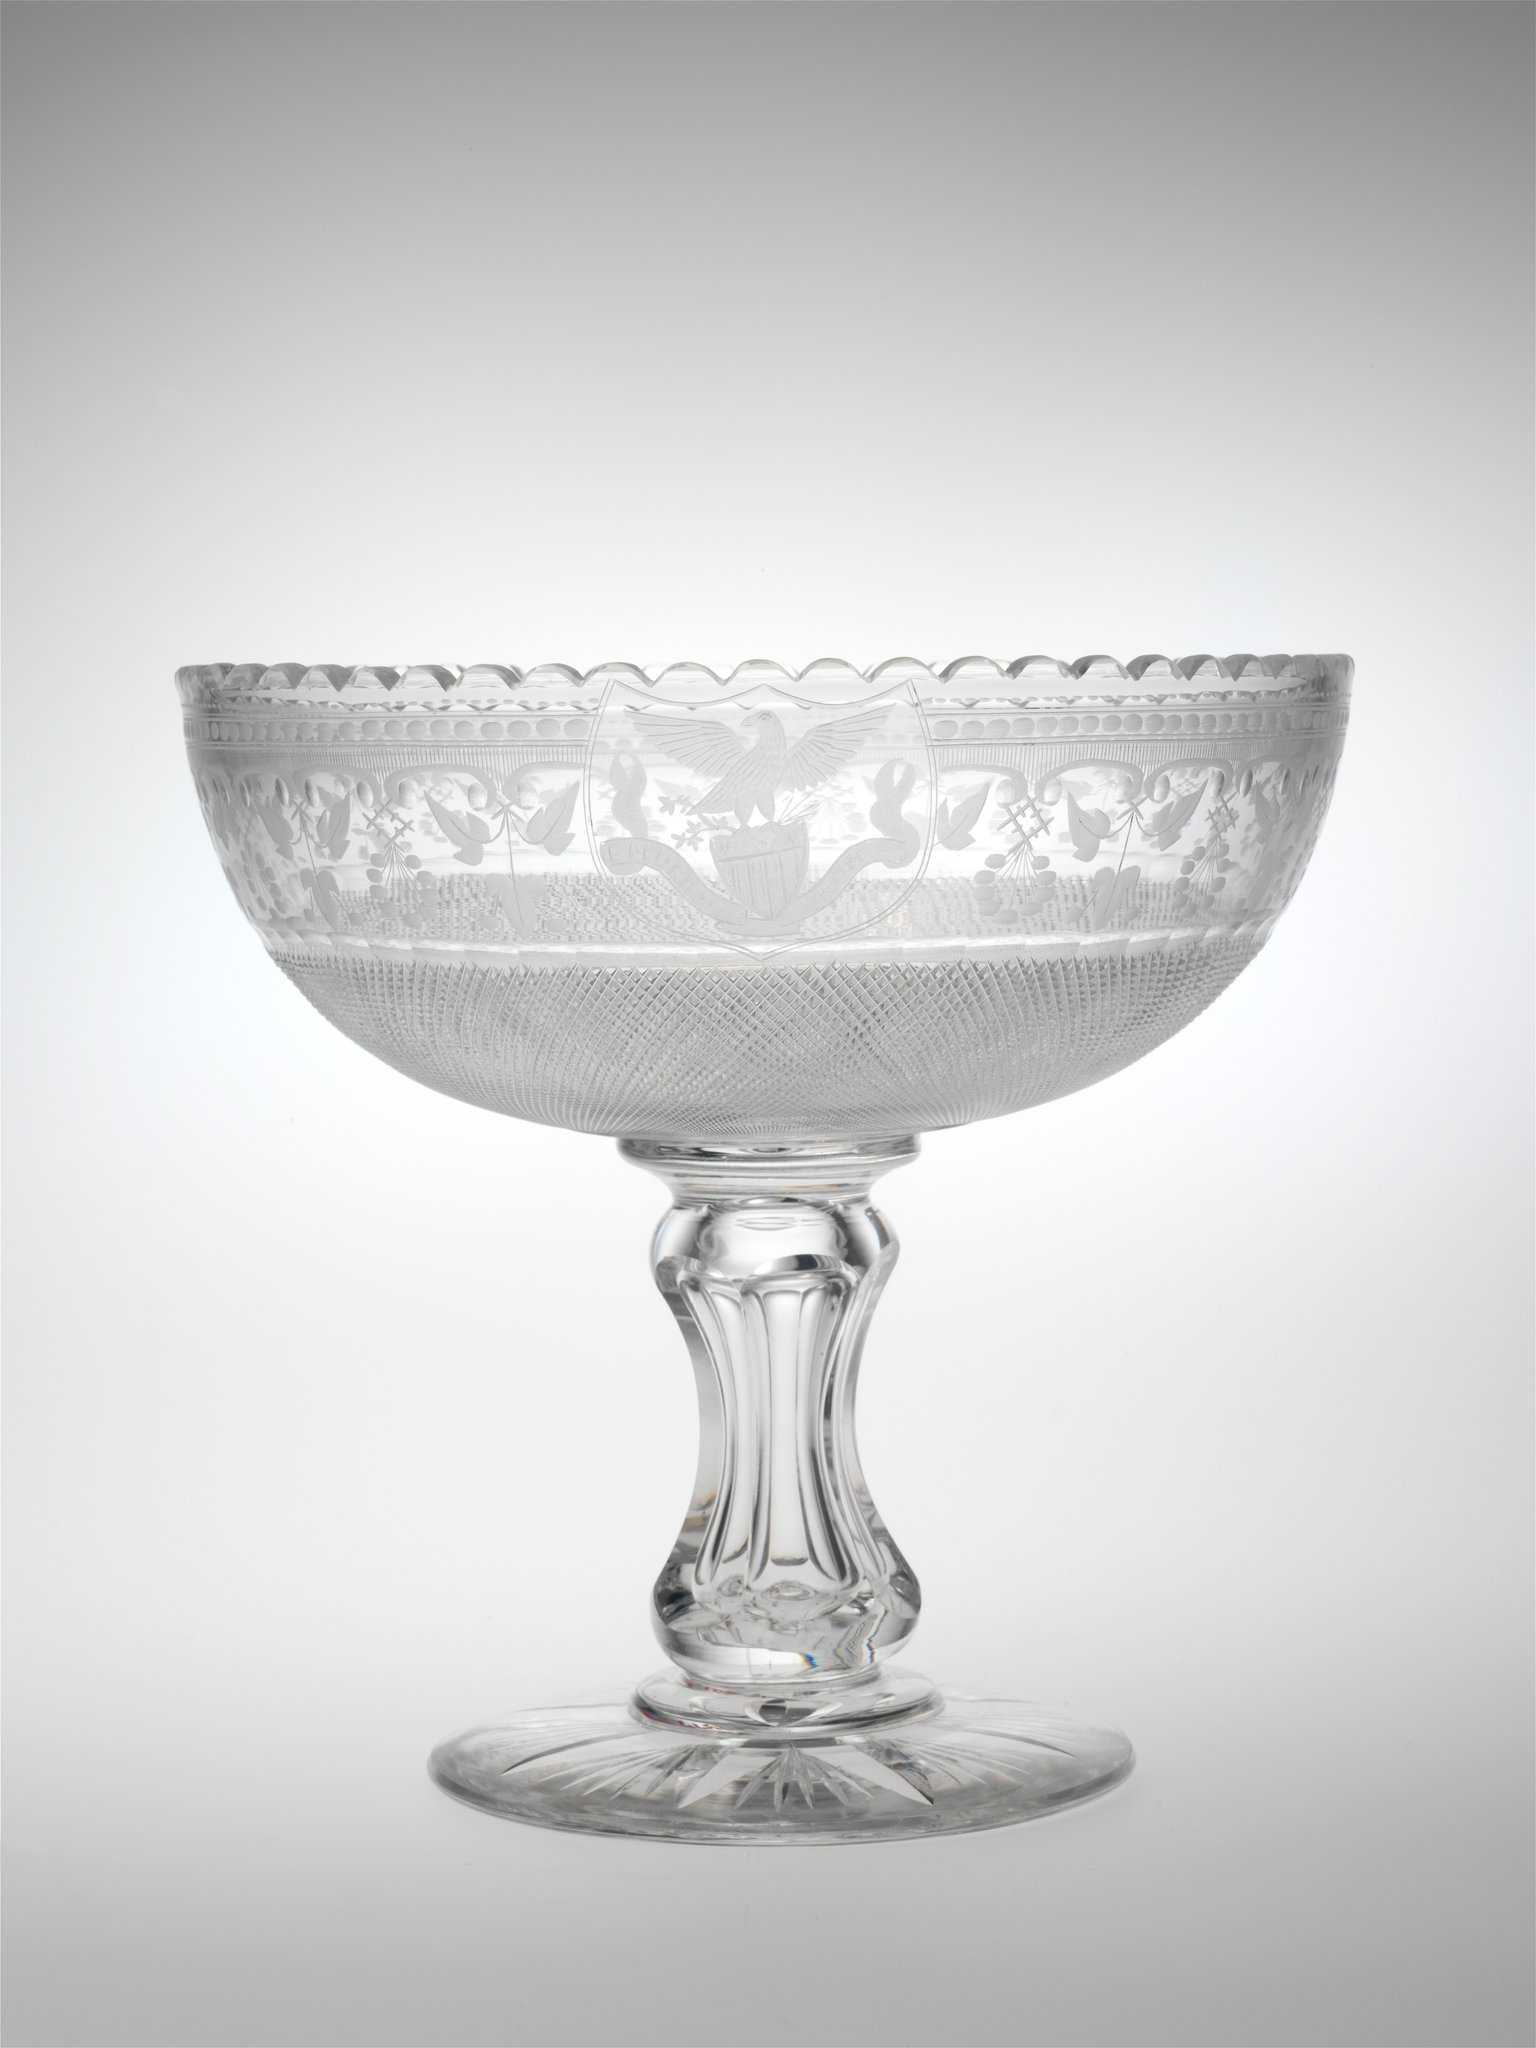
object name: compote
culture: american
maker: long island flint glass works of christian dorflinger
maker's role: artist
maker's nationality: american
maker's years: 1852-1863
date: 1861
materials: glass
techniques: glassblowing, cutting, engraving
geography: united states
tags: eagles